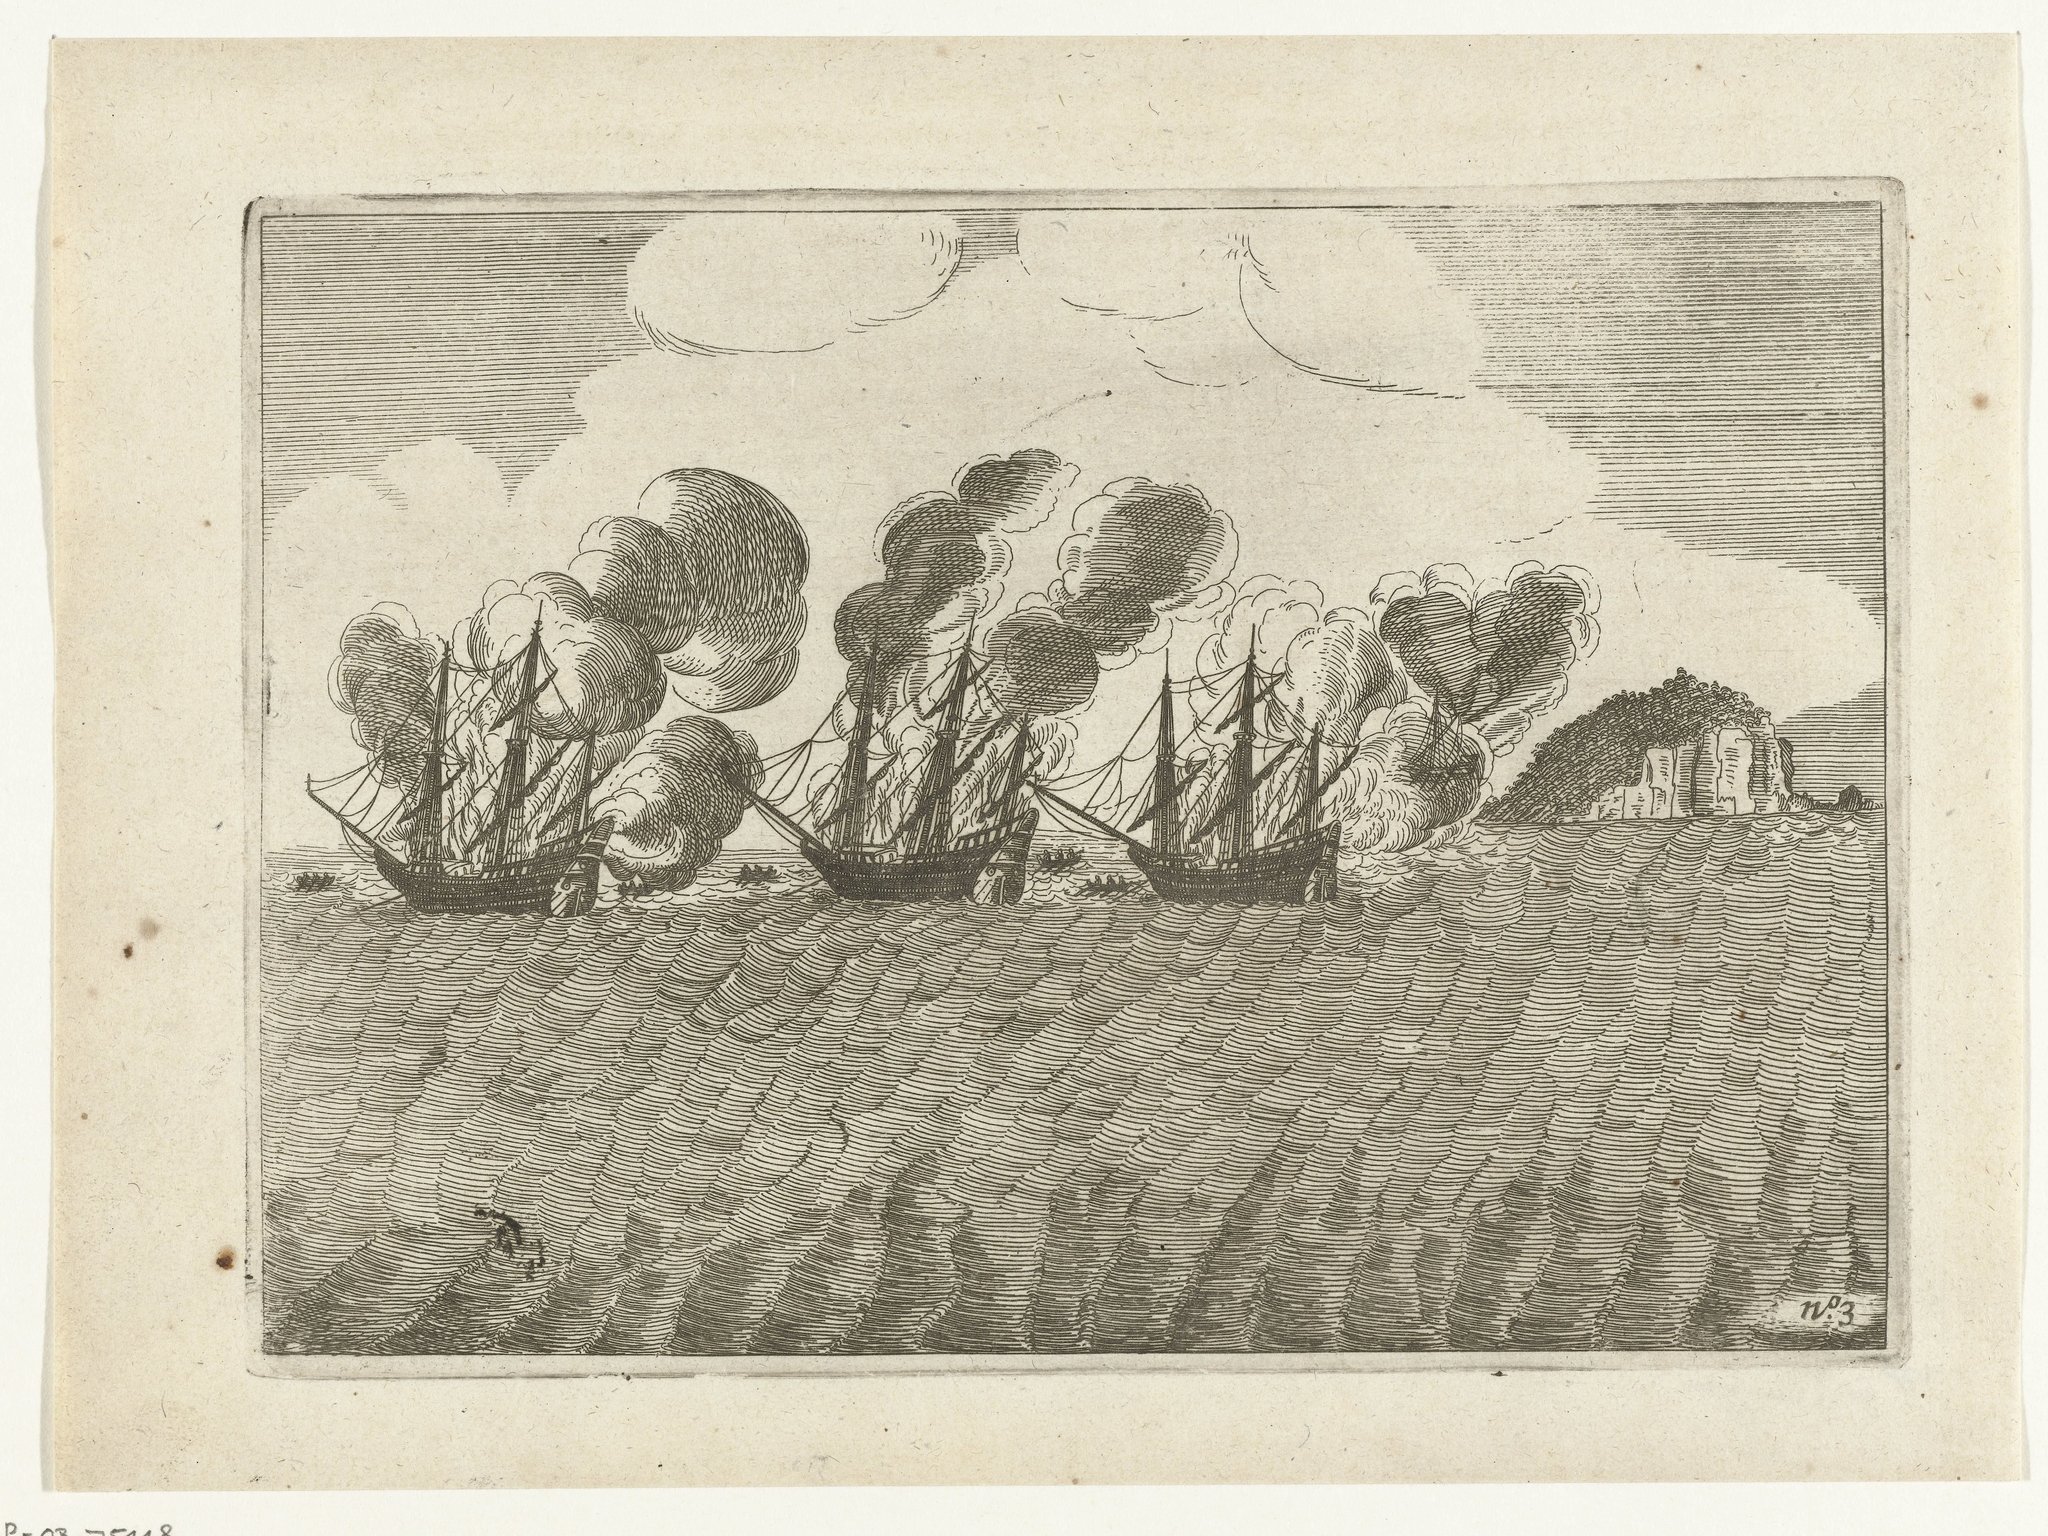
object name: print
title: Drie Portugese schepen bij Melaka in brand, 1606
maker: Anonymous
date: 1644-1646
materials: paper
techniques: etching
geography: northern netherlands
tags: rotterdam, mayor, shipwreck, landscapes in tropical and sub-tropical regions, exploration, expedition, voyage of discovery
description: Gebruikt als illustratie: Historisch Verhael Vande treffelijcke Reyse, gedaen naer de Oost-Indien ende China, met elf Schepen. Door den Manhaften Admirael Cornelis Matelief de Jonge. Inden Jaren 1605. 1606. 1607. ende 1608. Deze tekst opgenomen in : I. Commelin, Begin ende voortgangh, van de Vereenighde Nederlantsche Geoctroyeerde Oost-Indische Compagnie, J. Janssonius, Amsterdam 1646. Genummerd: No. 3.